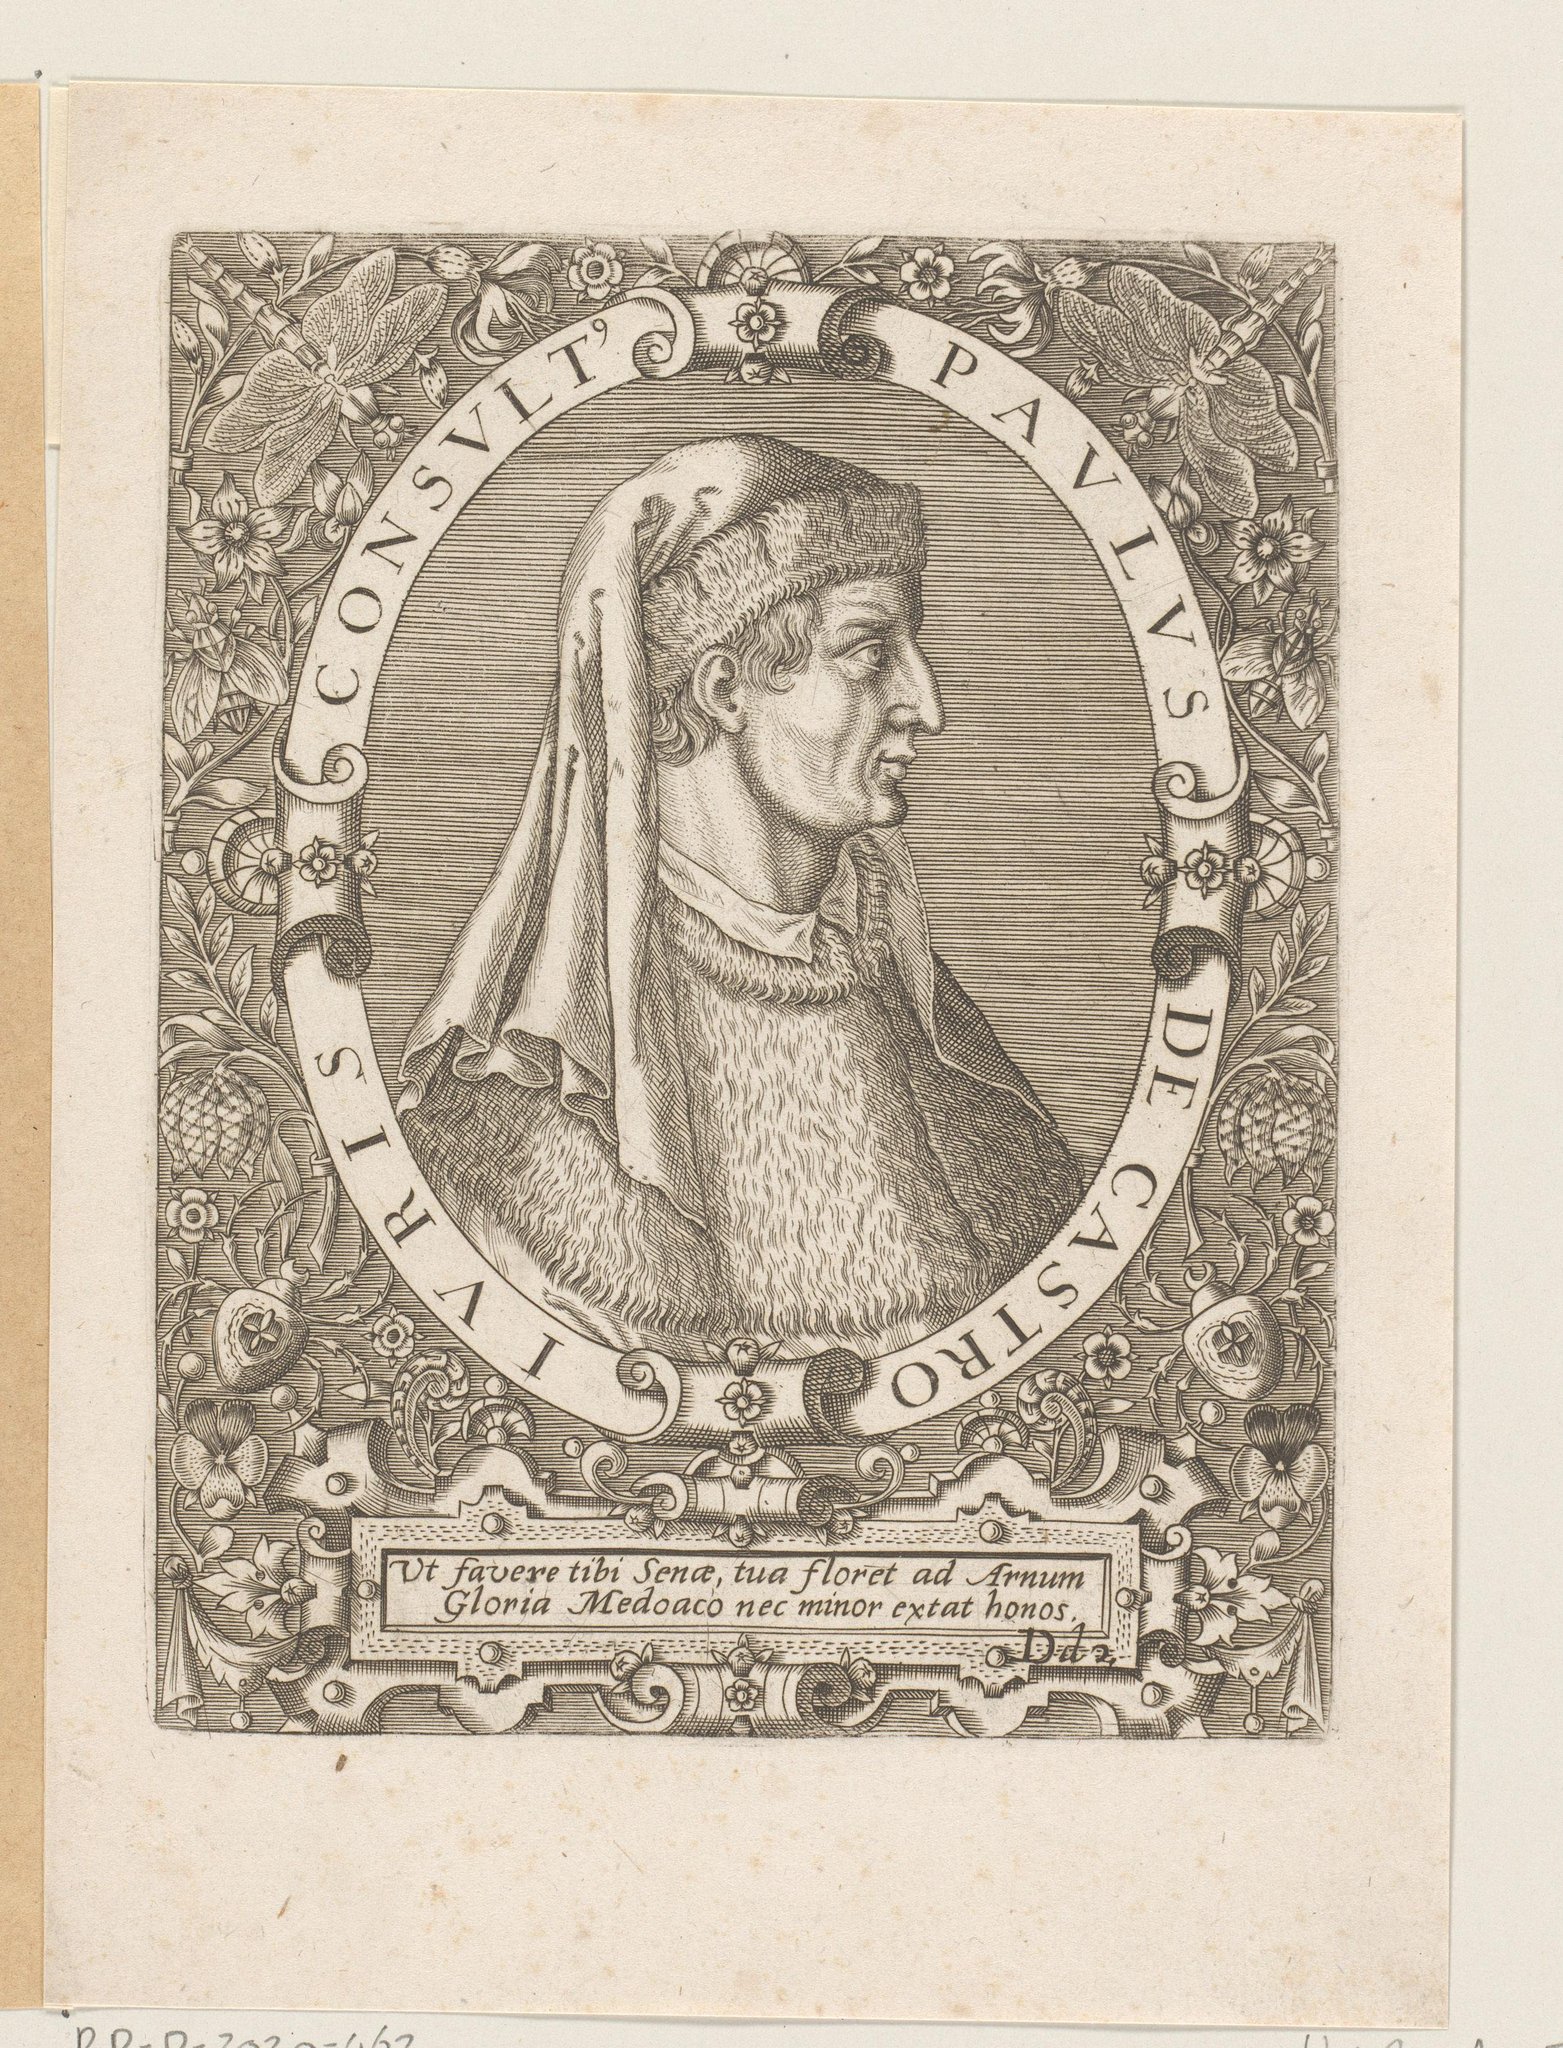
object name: book illustration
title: Paulus de Castro iuris consult[9]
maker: jean jacques boissard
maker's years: 1528-1598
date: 1650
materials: paper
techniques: engraving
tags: historical persons, lawyer, attorney at law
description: Prent gebruikt in: Boissard, Jean Jacques. Bibliotheca chalcographica. 8 dln. Frankfurt am Main: Johannes Ammon, 1650-1652. Ook gebruikt in latere edities. Eerdere staat van prent verschenen in: Boissard, Jean Jacques. Icones quinquaginta virorum illustrium doctrina & eruditione praestantium ad vivum effictae. 4 dln. Frankfurt am Main: s.n., 1597-1599. Mogelijk ook gebruikt in latere edities.